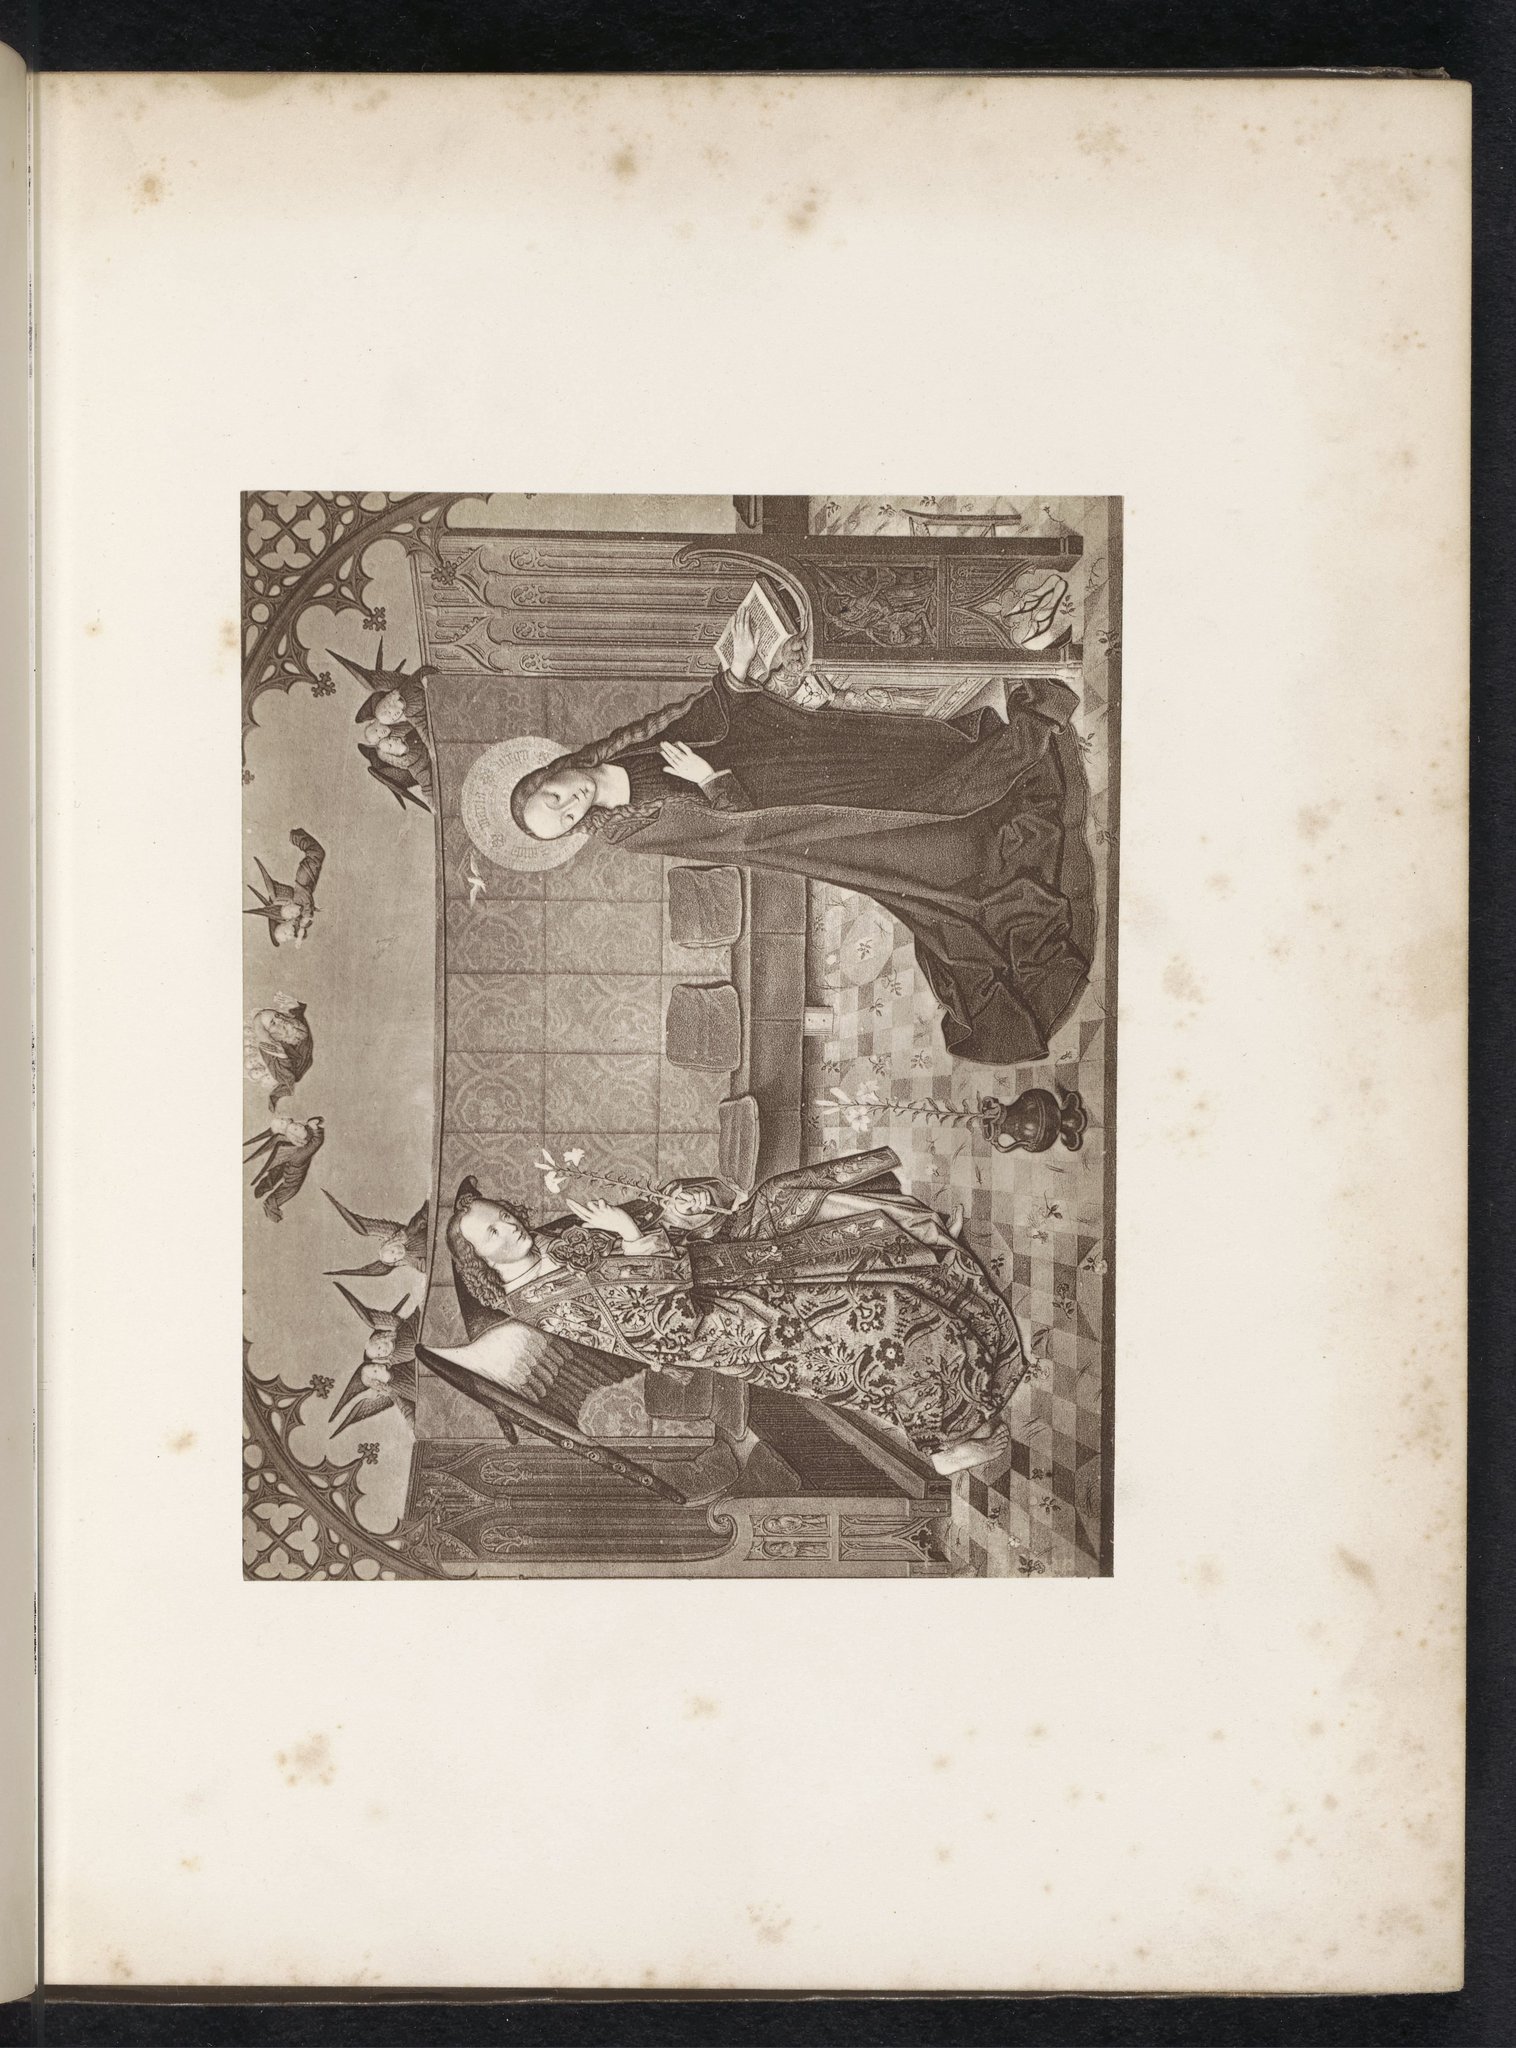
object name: photograph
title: Fotoreproductie van een prent naar een schilderij, voorstellende de Annunciatie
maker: Anonymous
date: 1859-1869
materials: photographic support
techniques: albumen print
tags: the annunciation: mary kneeling